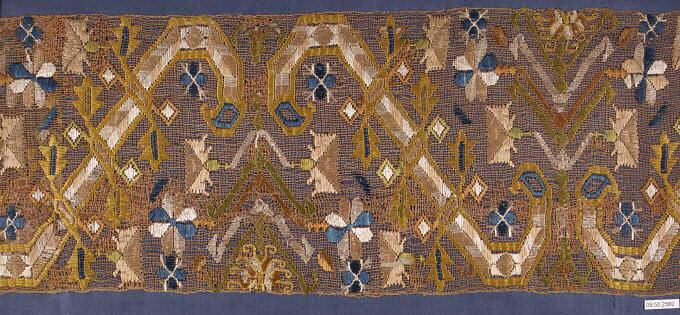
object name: strip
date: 1601-1700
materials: silk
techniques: embroidery